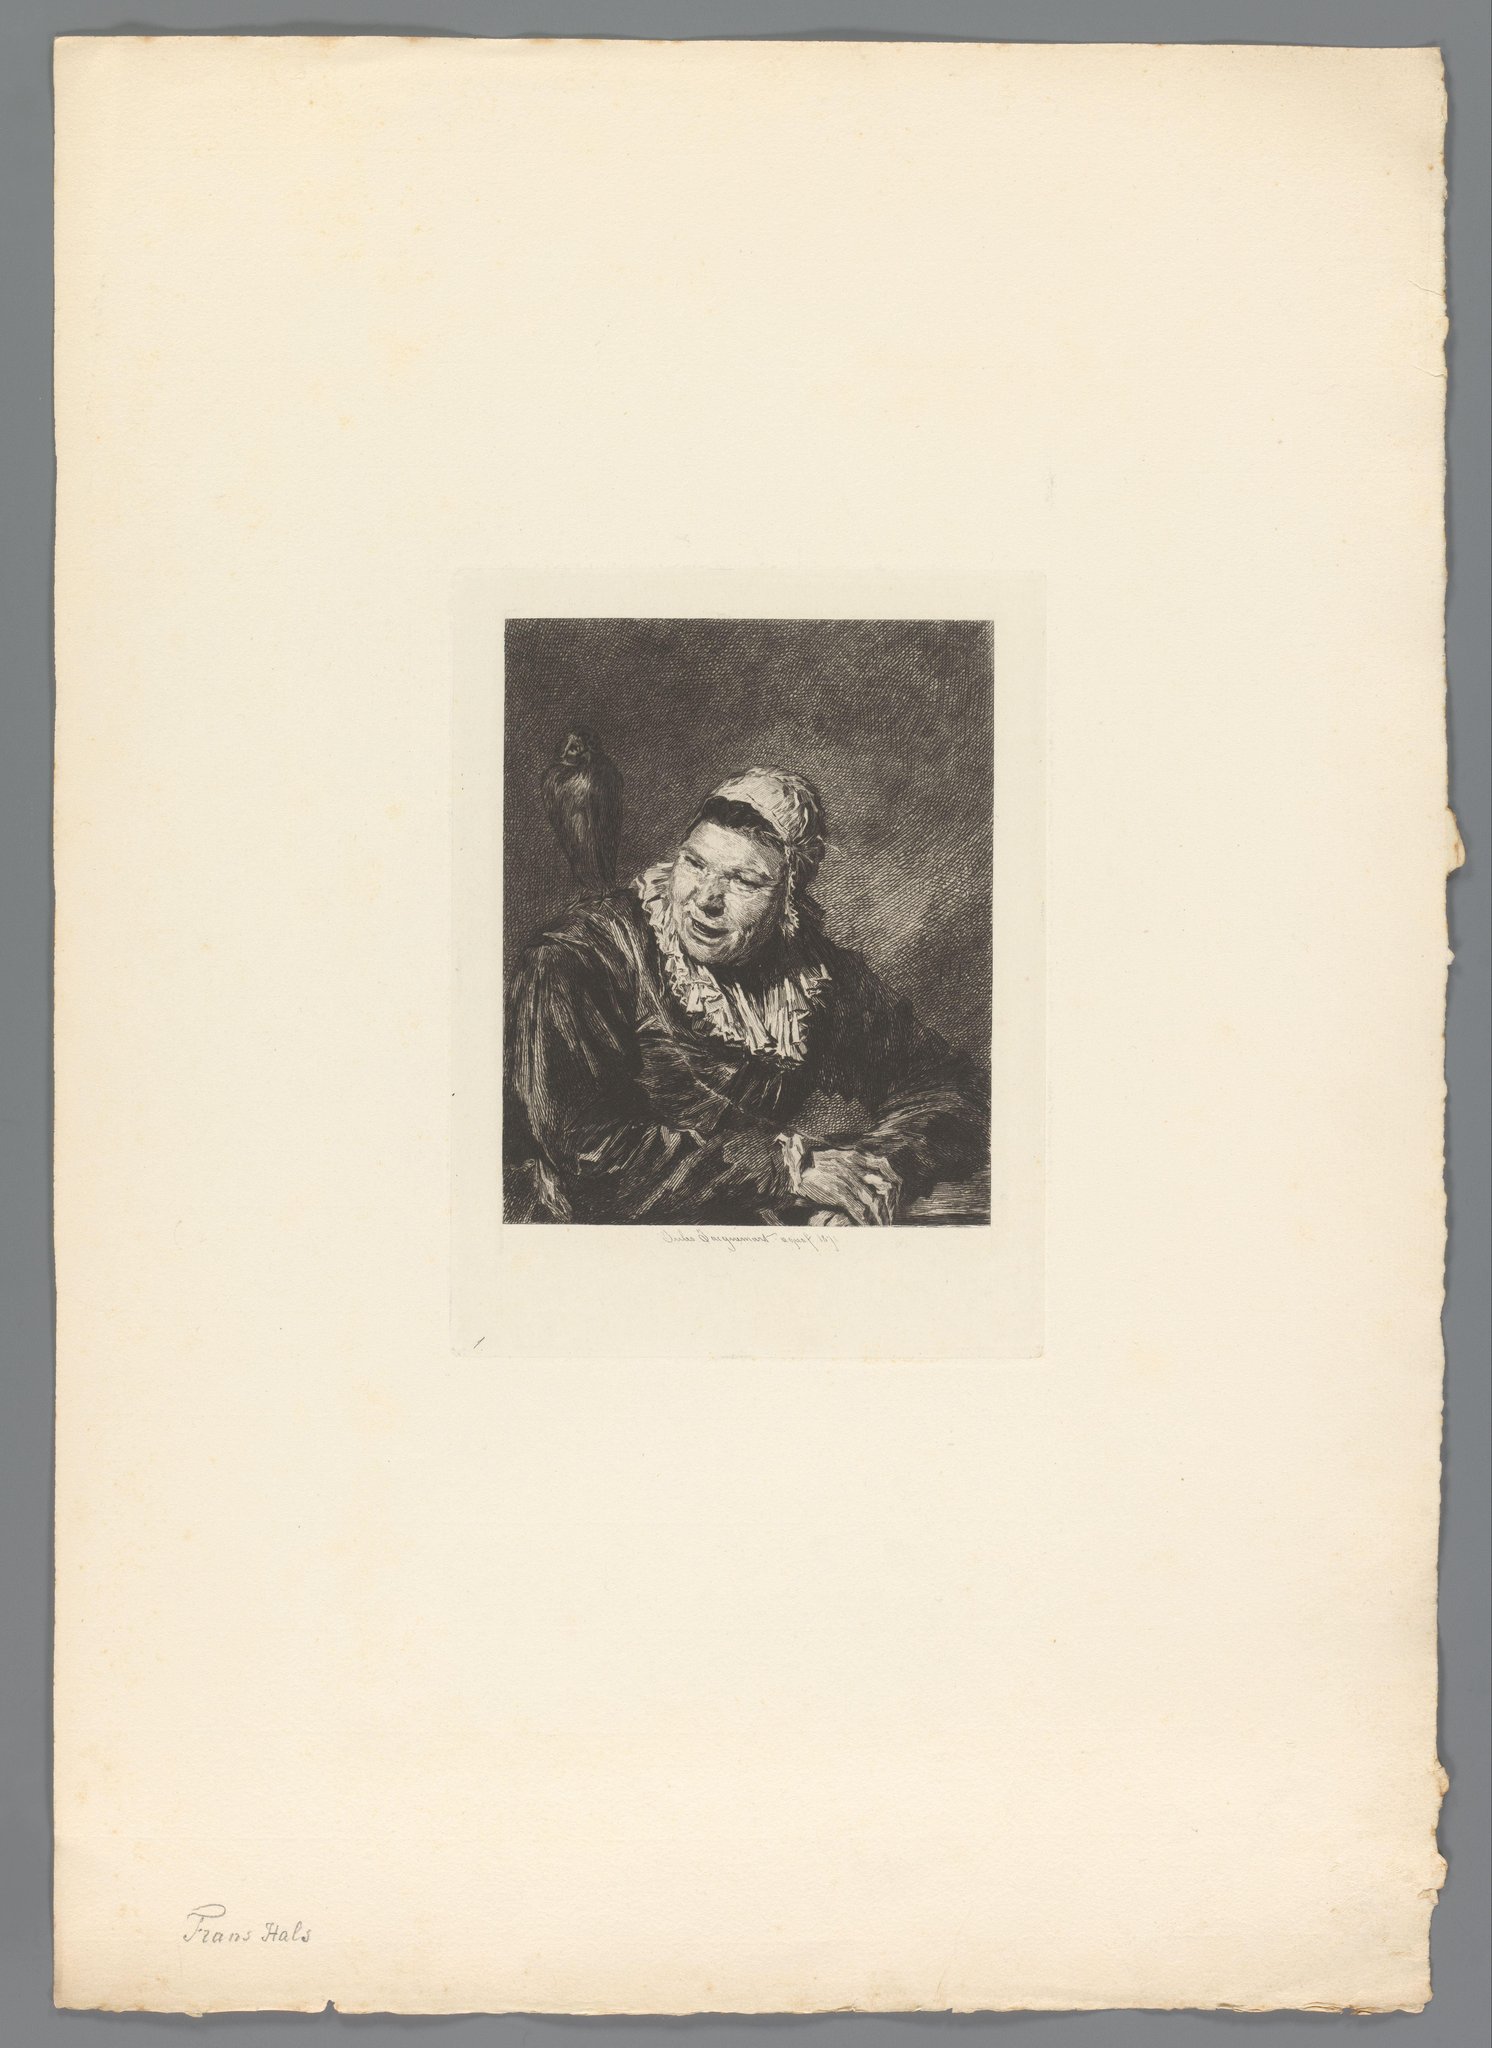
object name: print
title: Malle Babbe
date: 1871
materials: paper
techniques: etching, intaglio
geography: london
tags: witch, sorceress, owls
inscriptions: collector's mark: Lugt 2228, collector's mark: ‘Koninklijk Oudheidkundig Genootschap Amsterdam / Bibliotheek’, number: ‘1.’, inscription: ‘Frans Hals’